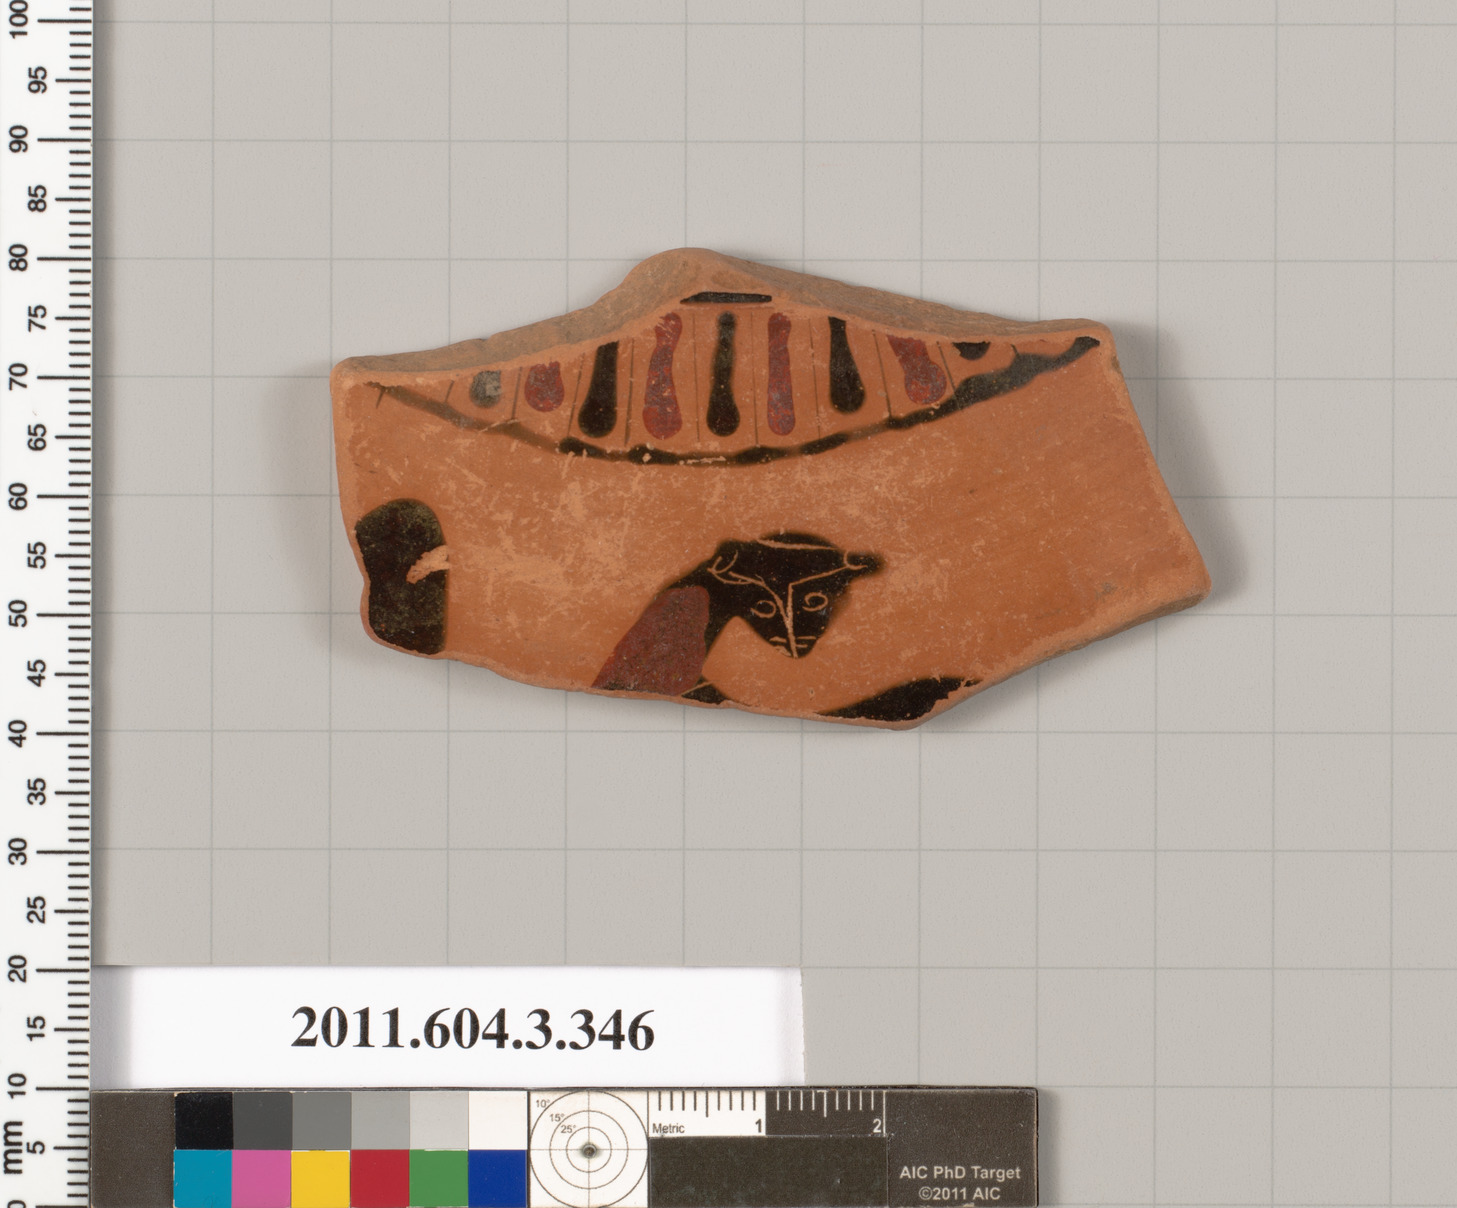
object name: neck amphora fragment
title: Terracotta fragment of a neck-amphora (jar)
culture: greek, attic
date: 567-535 BCE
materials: terracotta